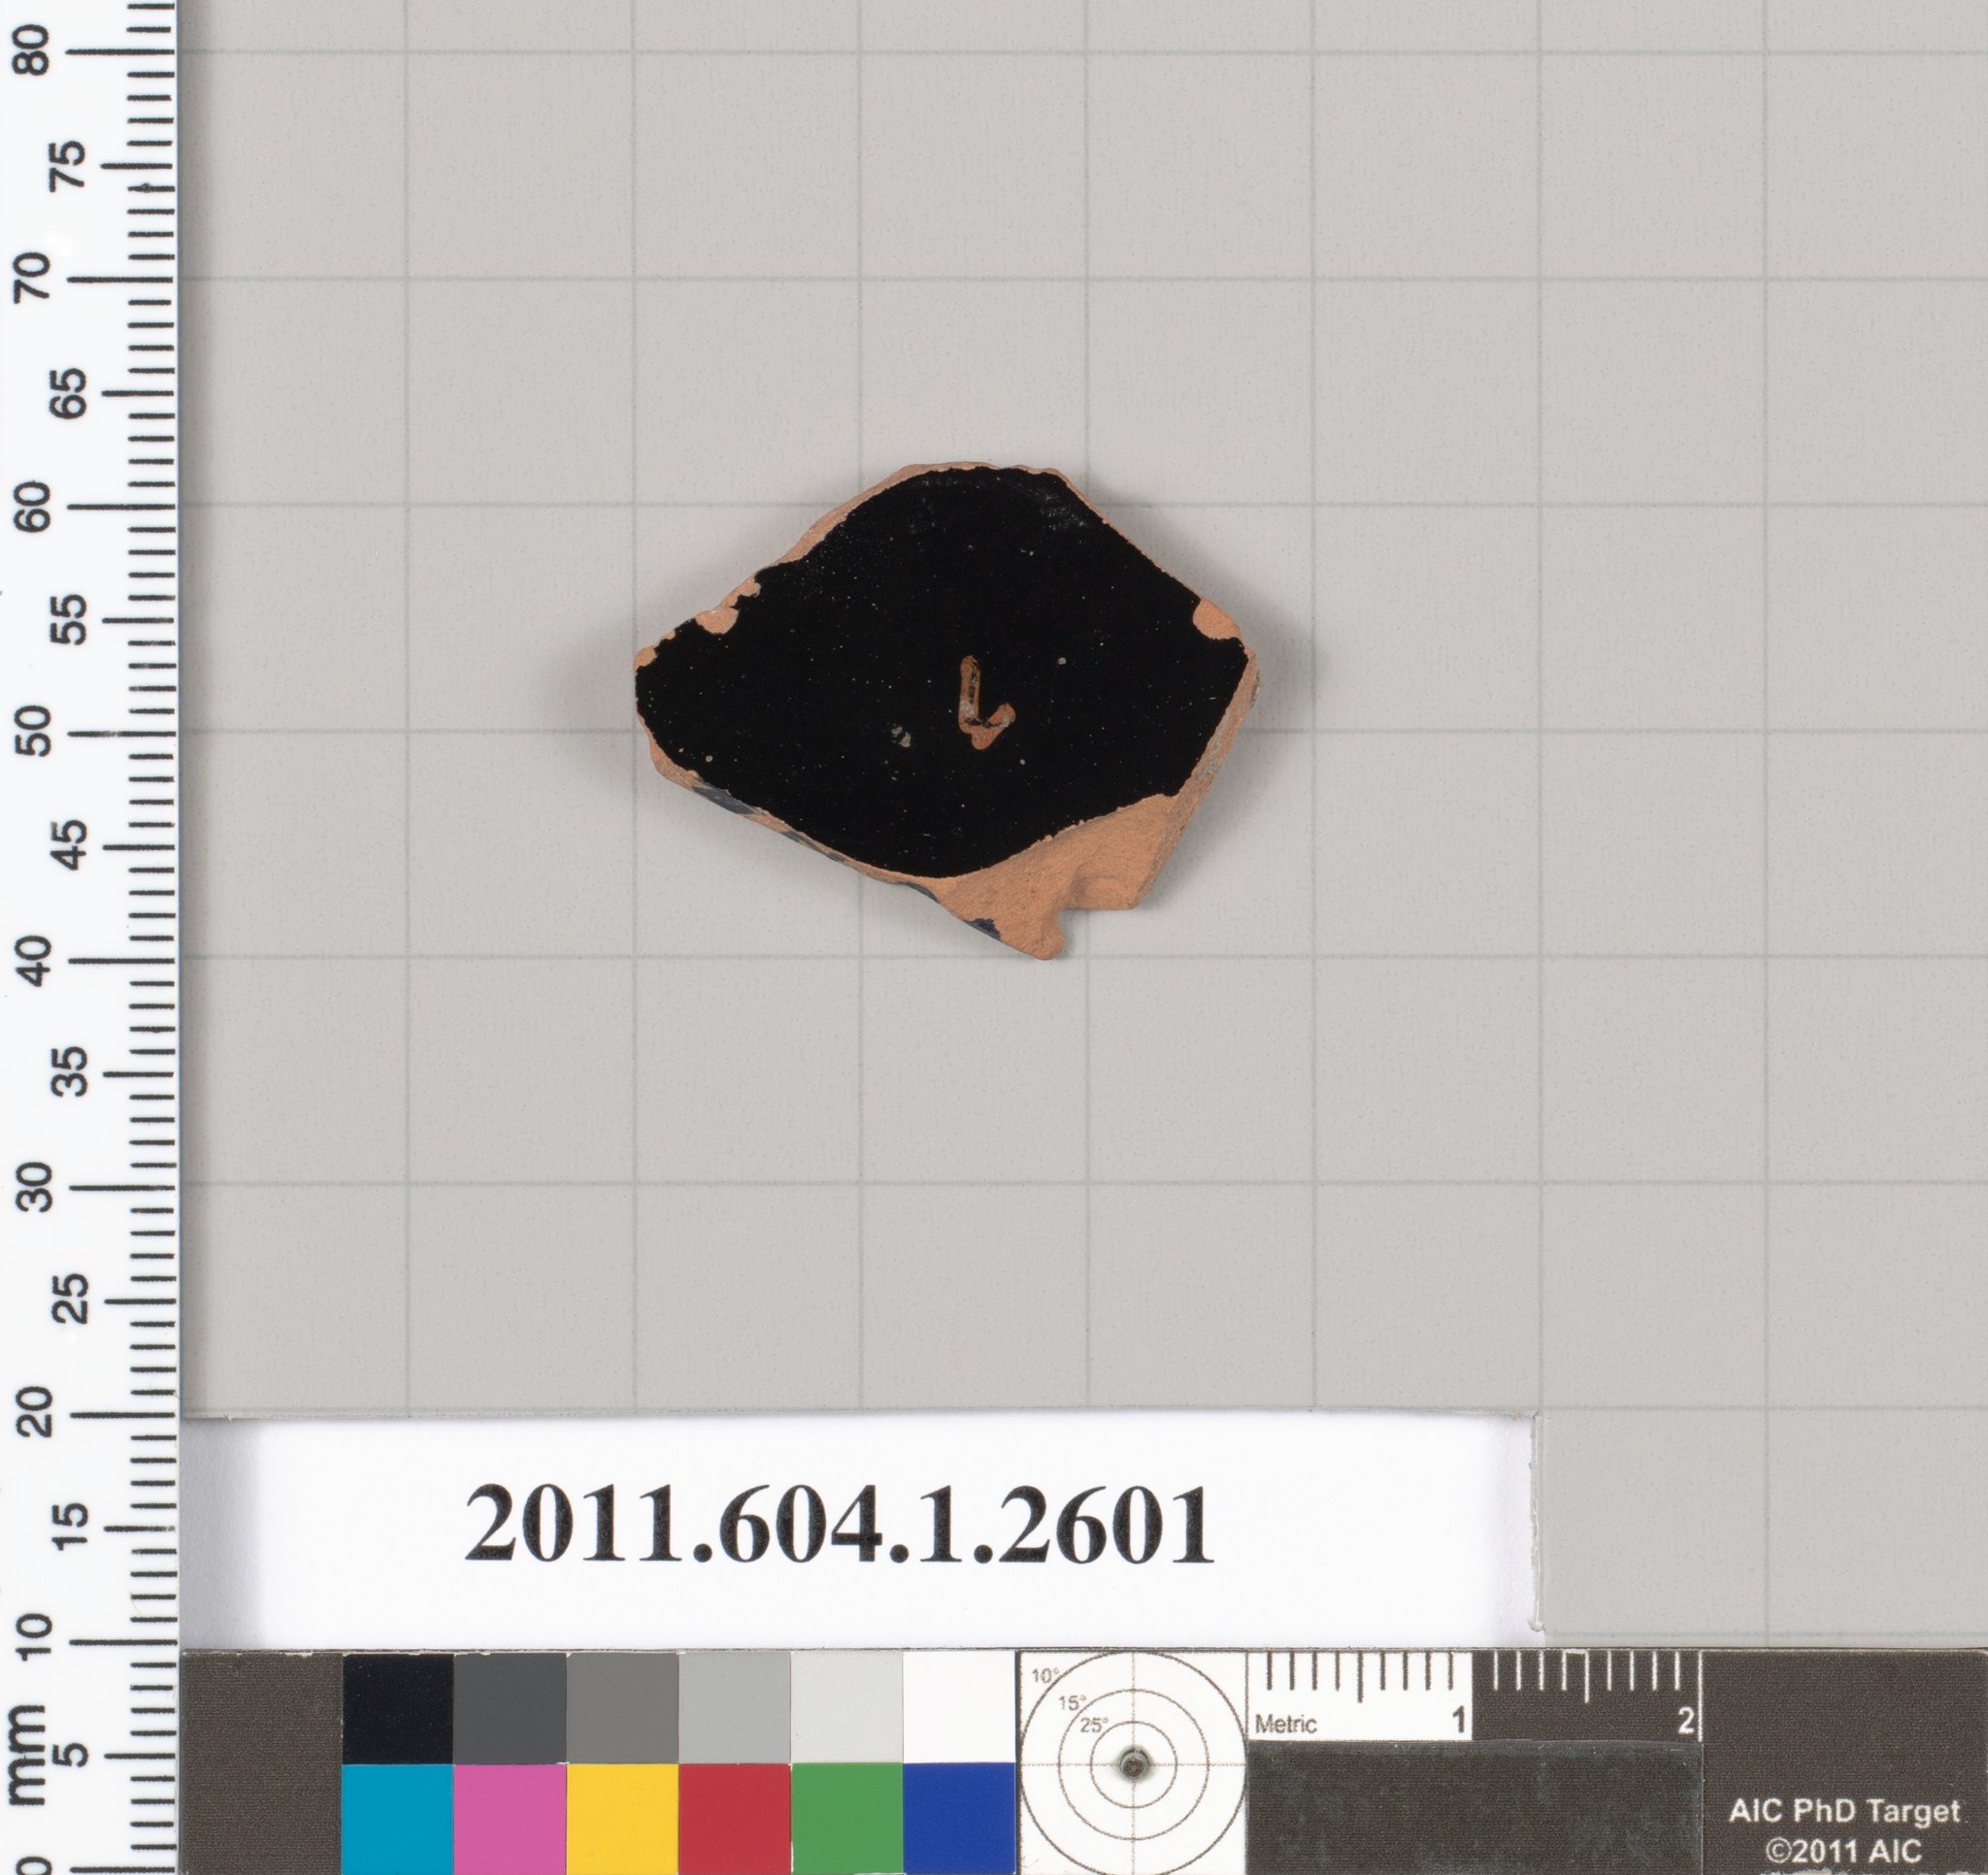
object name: kylix fragment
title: Terracotta fragment of a kylix (drinking cup)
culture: greek, attic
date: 500-451 BCE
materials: terracotta